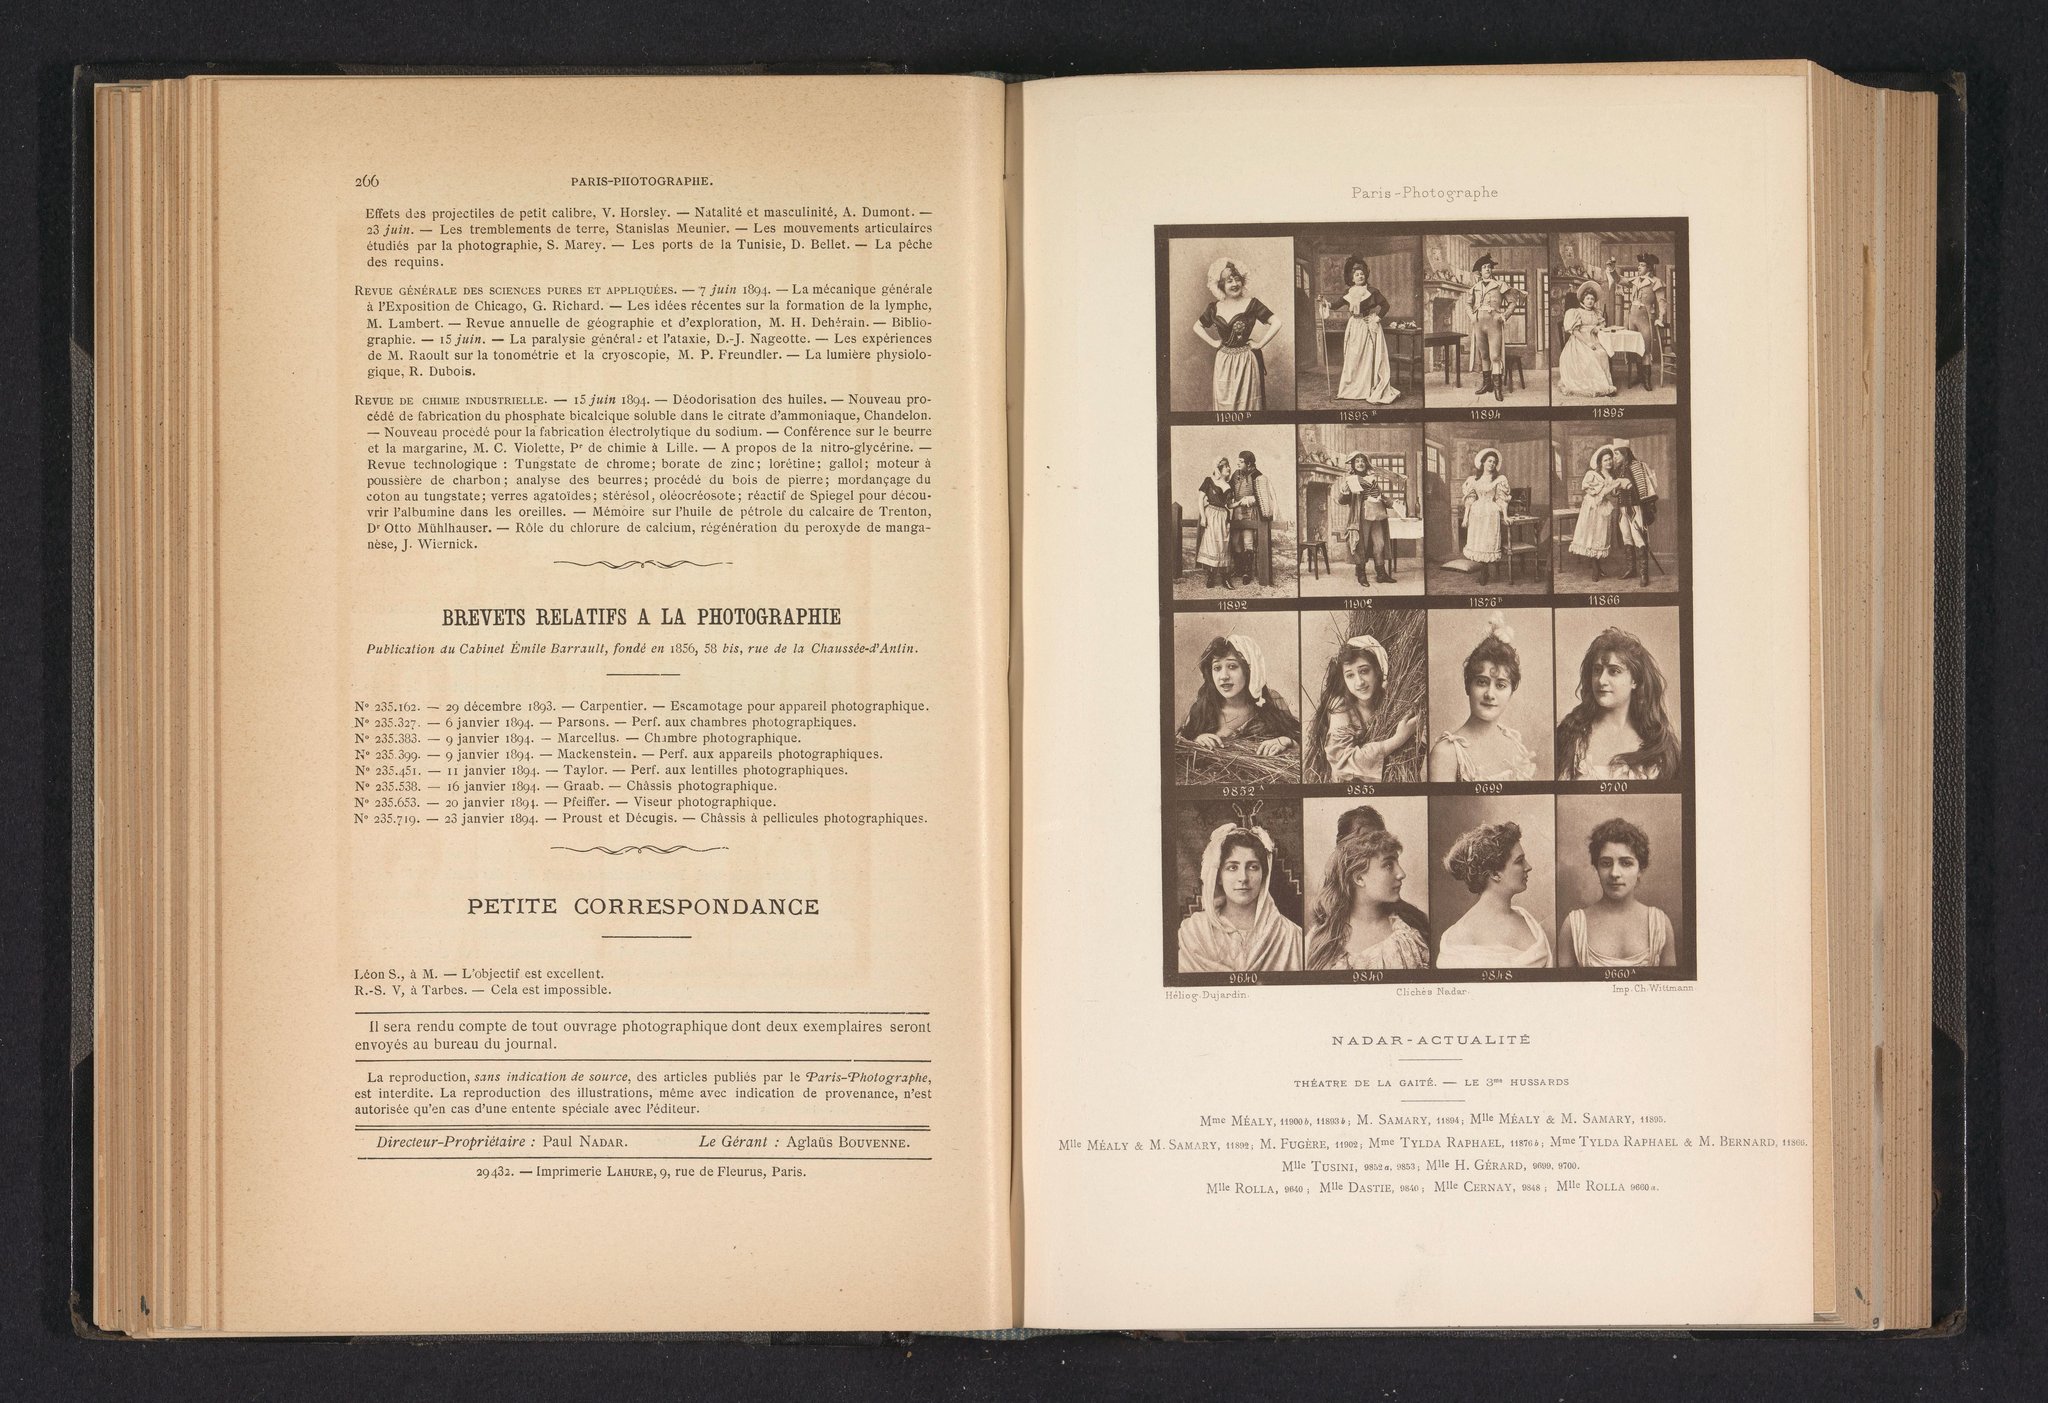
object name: photomechanical print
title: Zestien portretten van acteurs en actrices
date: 1884-1894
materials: paper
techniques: photoaquatint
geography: france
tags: portrait of actor, actress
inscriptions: number: ‘11900B (...) 9660A’, inscription: ‘Théatre de la Gaité. - Le 3me Hussards.’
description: Van links naar rechts: Juliette Méaly, M. Samary, Lucien Fugère, Mme Tylda Raphael, M. Bernard, Mlle Tusini, Mlle H. Gérard, Mlle Rolla, Mlle Dastie, Mlle Cernay.